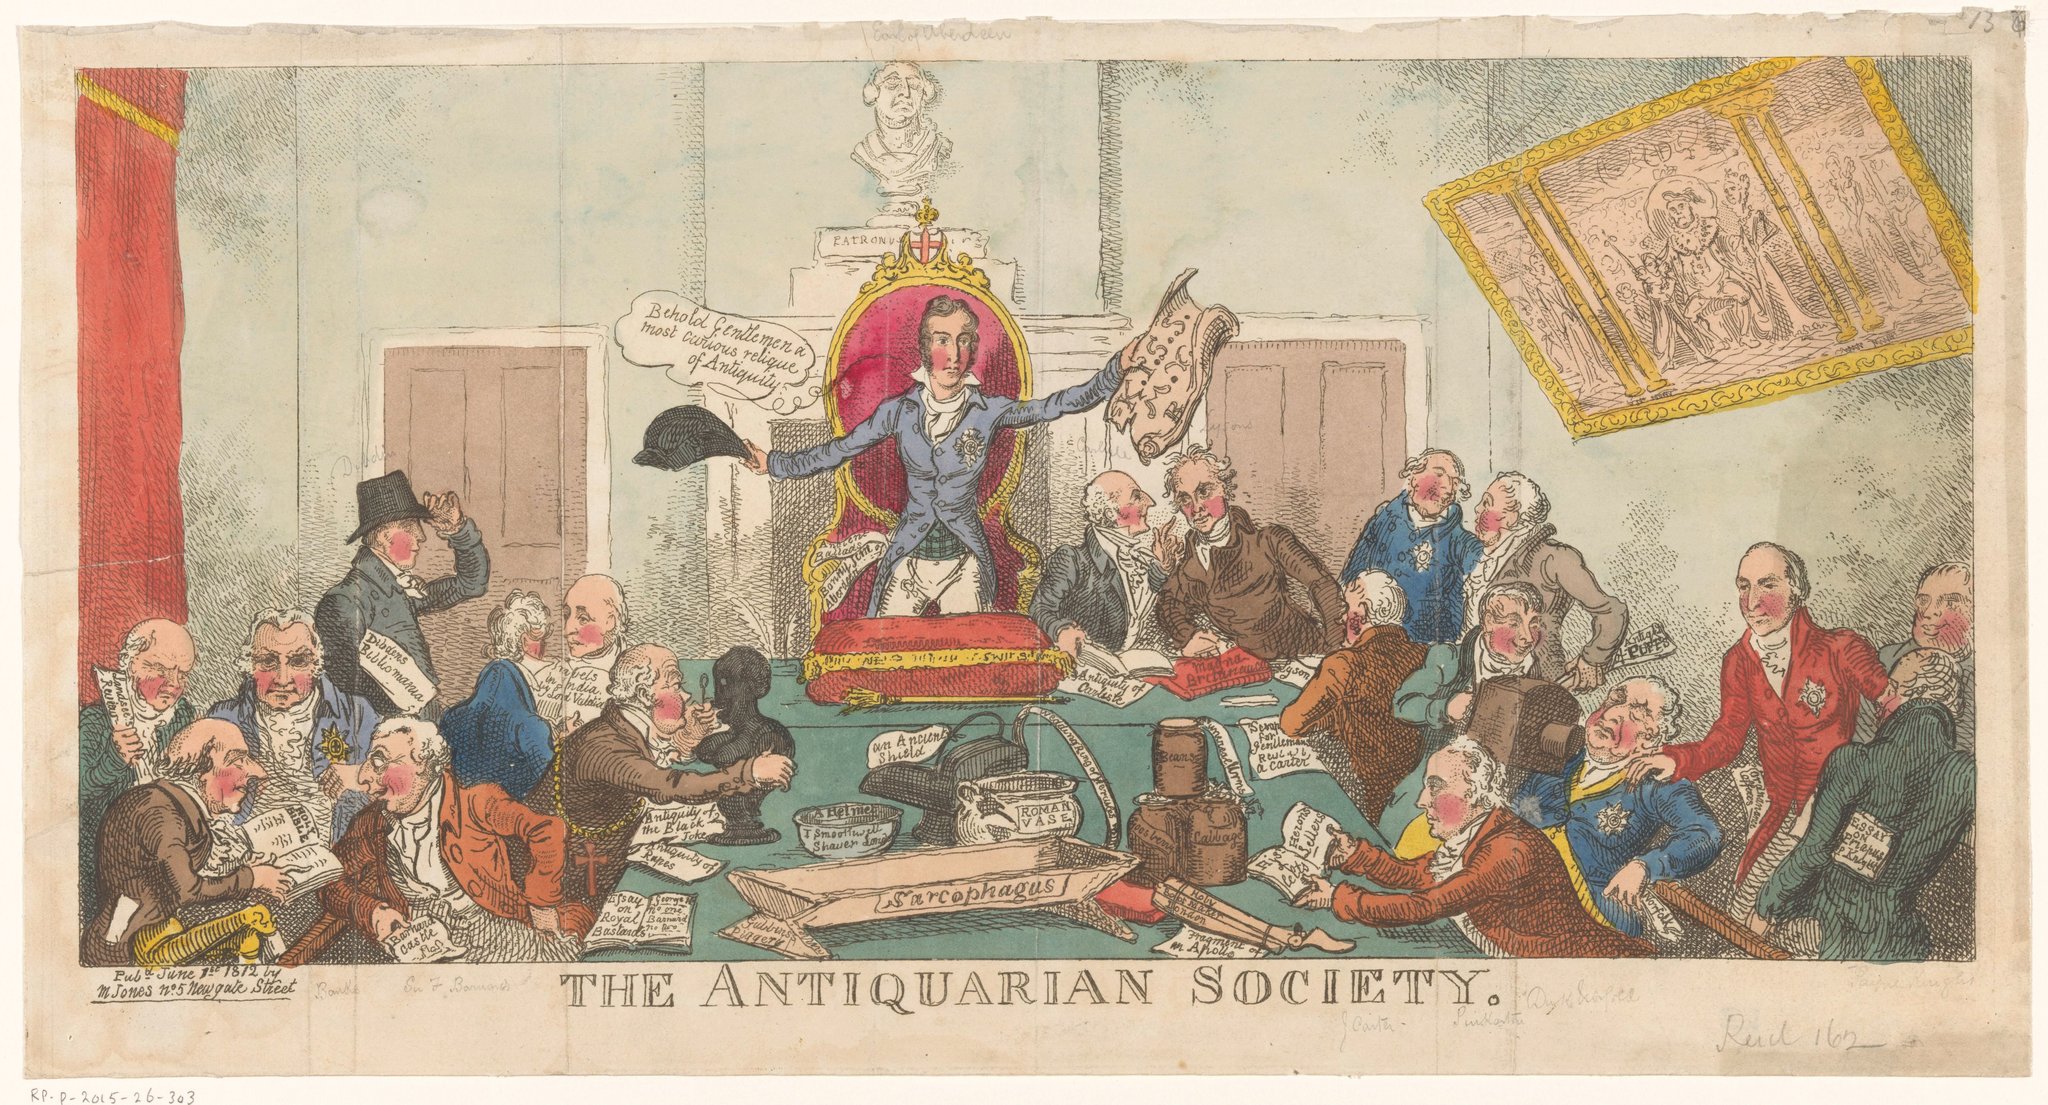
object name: print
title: The Antiquarian Society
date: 1812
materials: paper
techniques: etching, hand coloring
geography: london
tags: publisher, learned society, academy of sciences, historical person (with name) - historical person (with name) portrayed in a group, in a group-portrait, caricatures (human types)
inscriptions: collector's mark: Lugt 2228, collector's mark: Lugt 4779, collector's mark: Lugt 4780, watermark: ‘BGW 1812’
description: Vergadering van The Antiquarian Society met aan het hoofd van de tafel de voorzitter op zijn zetel, onder een buste van koning George III van Engeland. Op de tafel verschillende antiquiteiten en aan de muur een schilderij met Hendrik VIII van Engeland. Rondom de tafel zitten of staan de leden van het genootschap: personen uit het Britse culturele leven, grotendeels te identificeren aan de hand van de objecten of geschriften die ze hanteren.